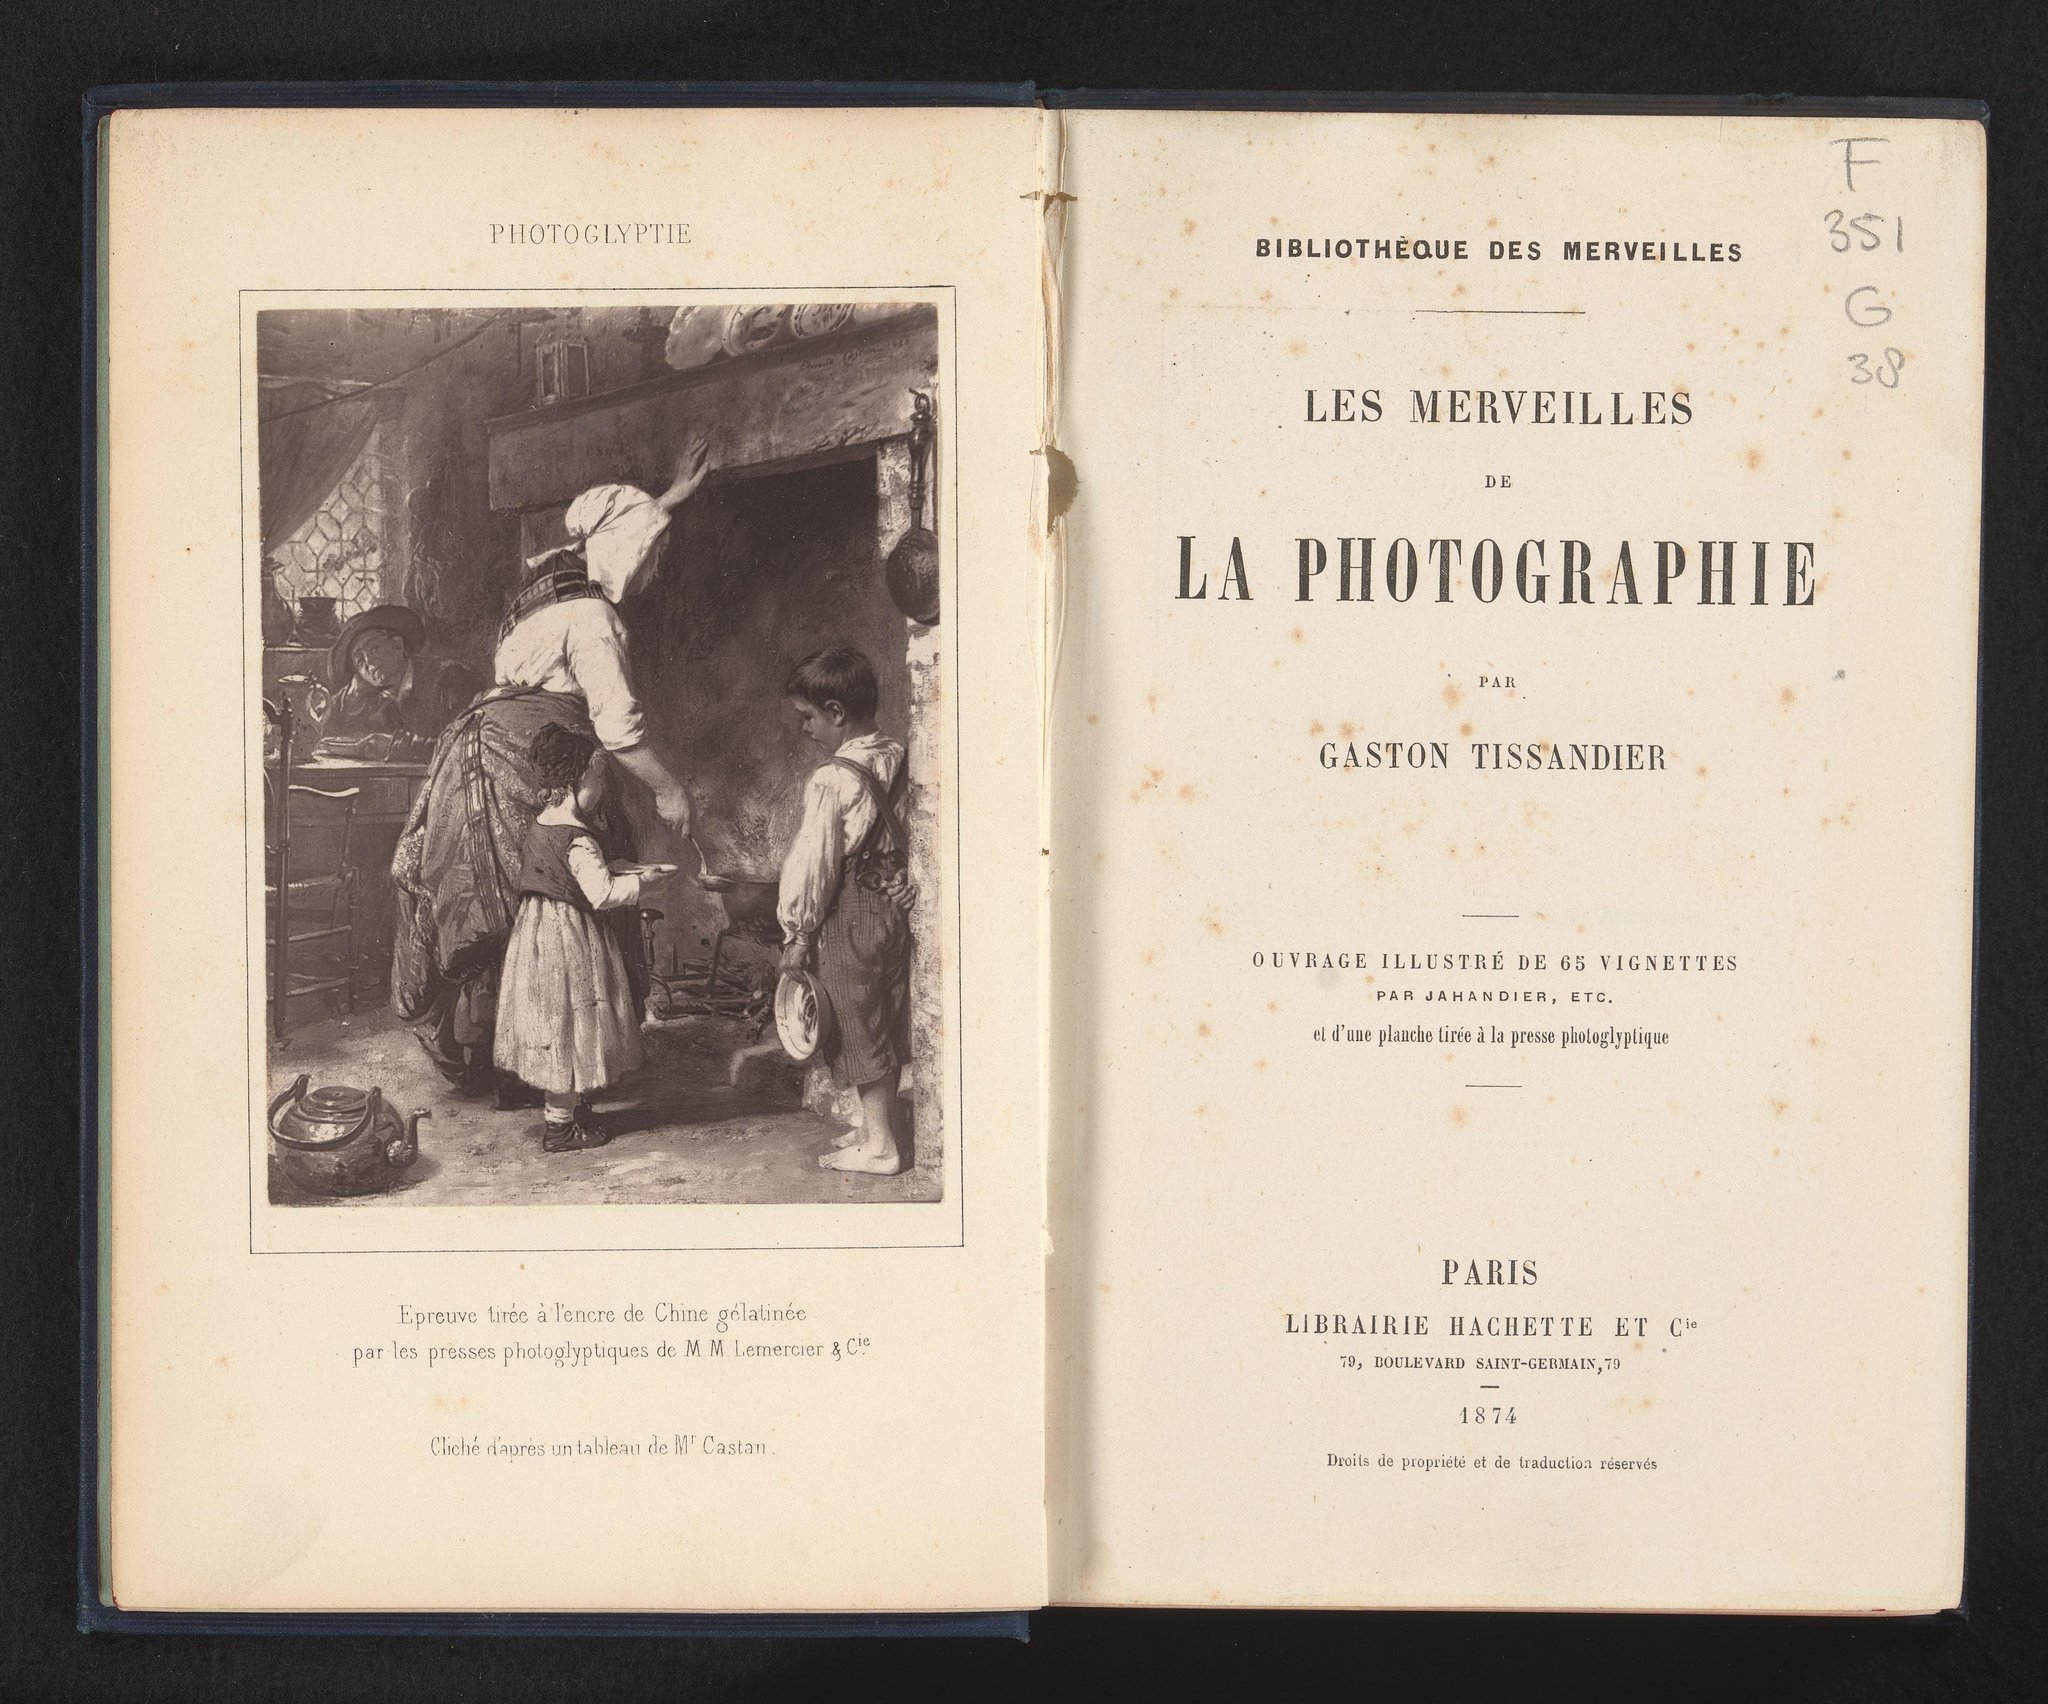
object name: photomechanical print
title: Fotoreproductie van een schilderij van een moeder met twee kinderen bij een haard, door Pierre Jean Edmond Castan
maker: pierre jean edmond castan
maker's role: print maker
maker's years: 1817-1892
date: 1869-1874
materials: paper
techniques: woodburytype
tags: open hearth, fire-place, mother and child(ren), woman and child(ren) (family group)